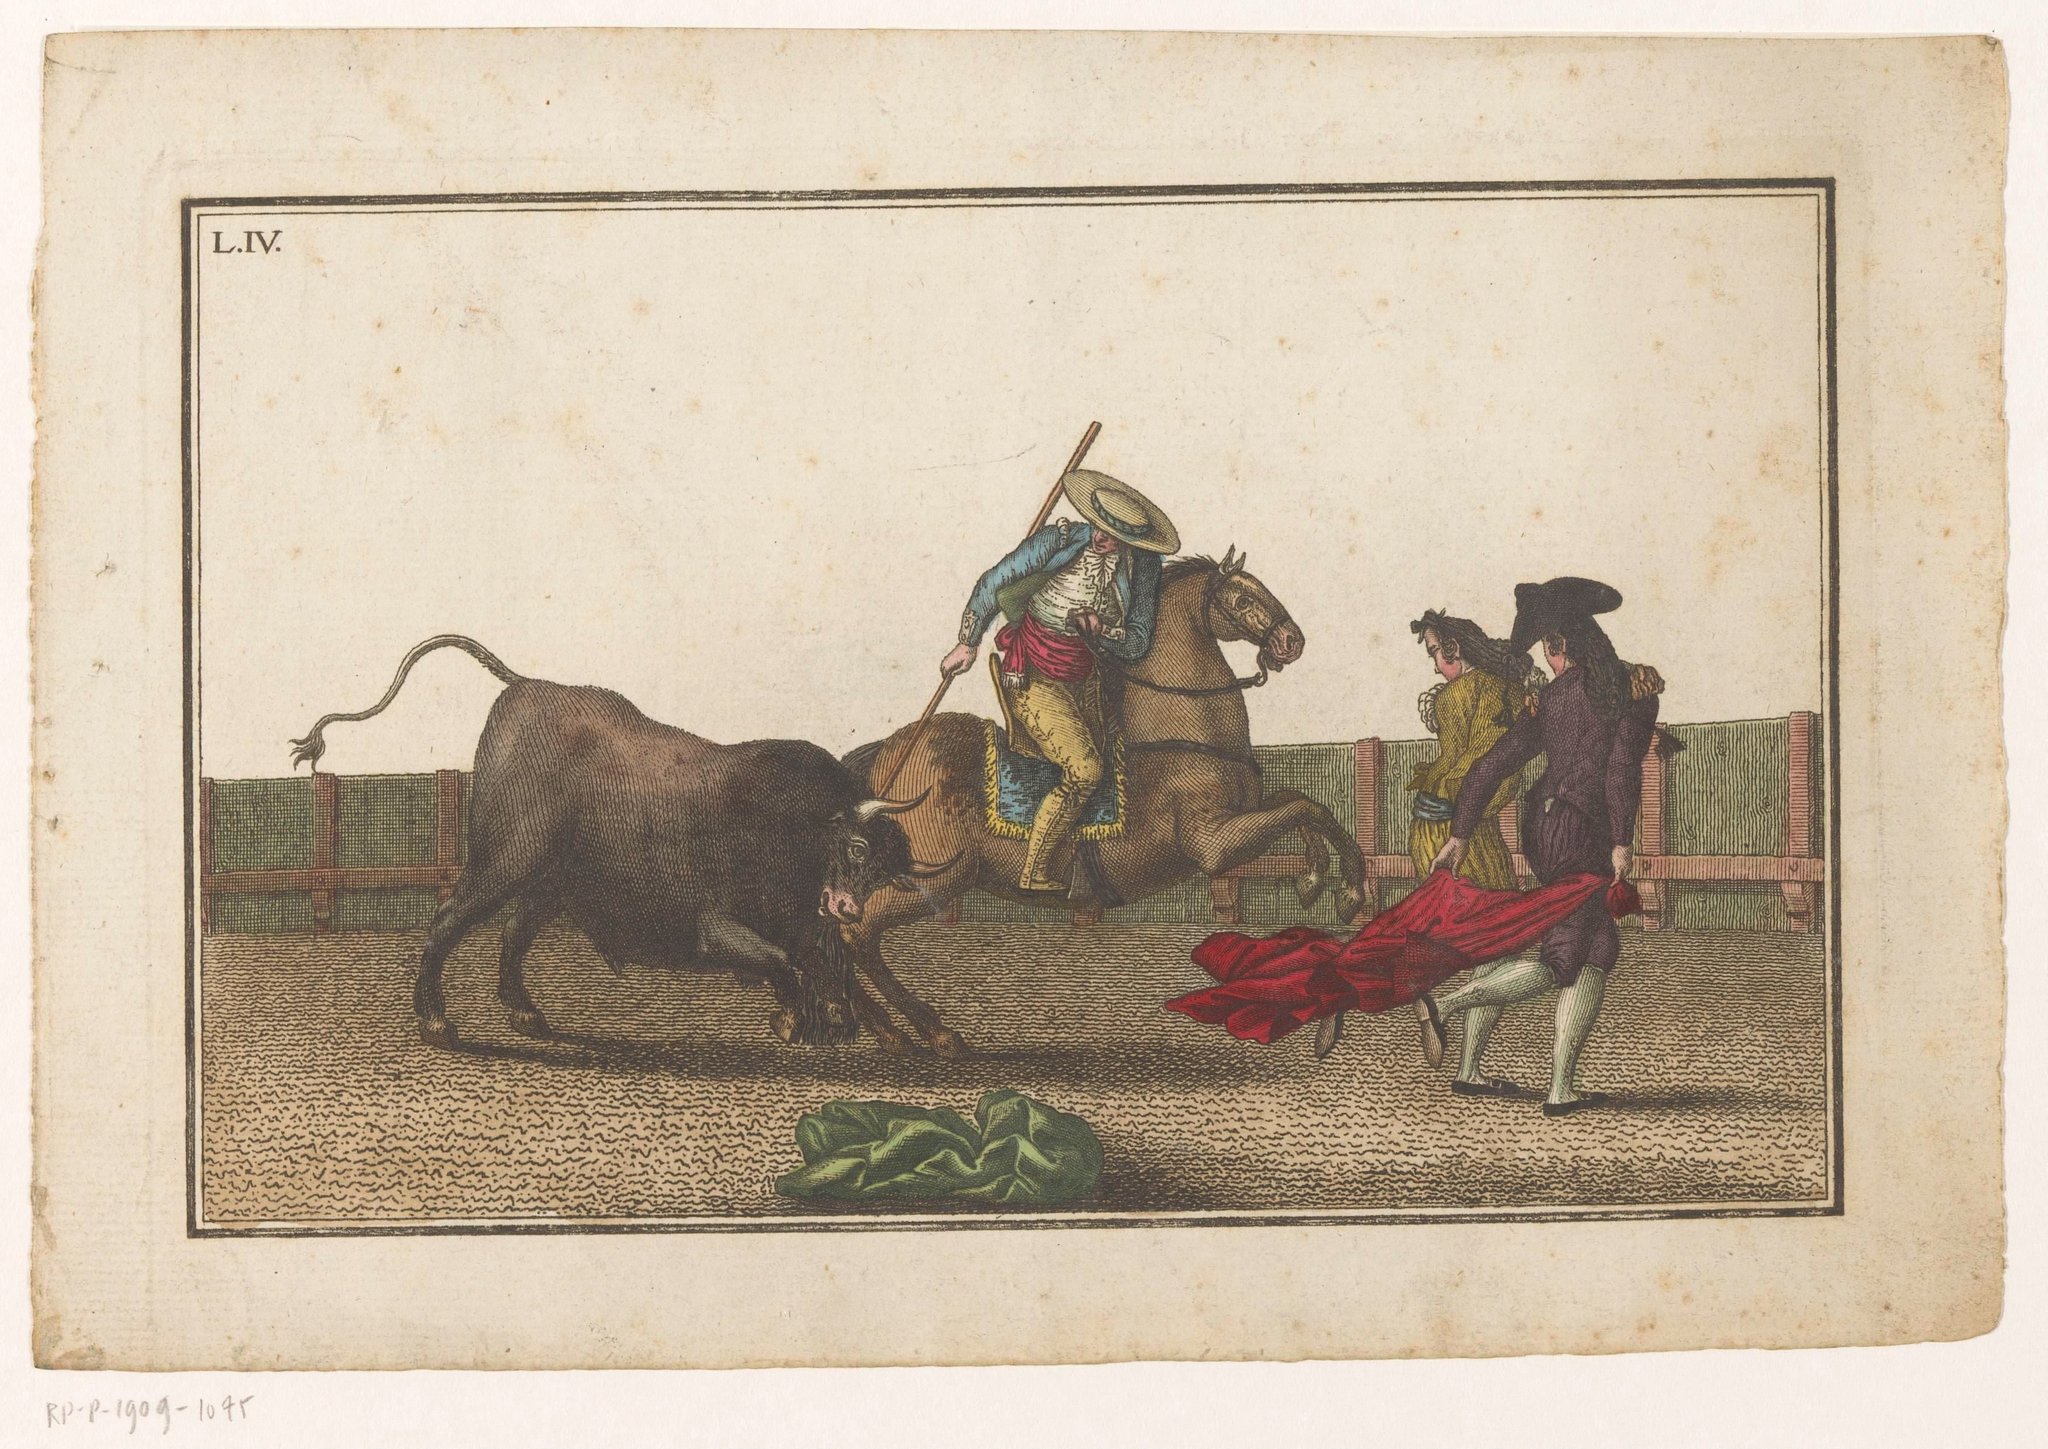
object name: print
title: Coleccion de las principales suertes de una corrida de toros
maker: luis fernández noseret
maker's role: print maker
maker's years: 1793-1828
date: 1795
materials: paper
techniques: etching, hand coloring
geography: spain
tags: bullfight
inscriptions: collector's mark: Lugt 2228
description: Deze prent maakt deel uit van een serie, bestaande uit twaalf prenten met voorstellingen van stierenvechten. Het betreft kopieën door Luis Fernandez Noseret naar de serie door Antonio Carnicero.